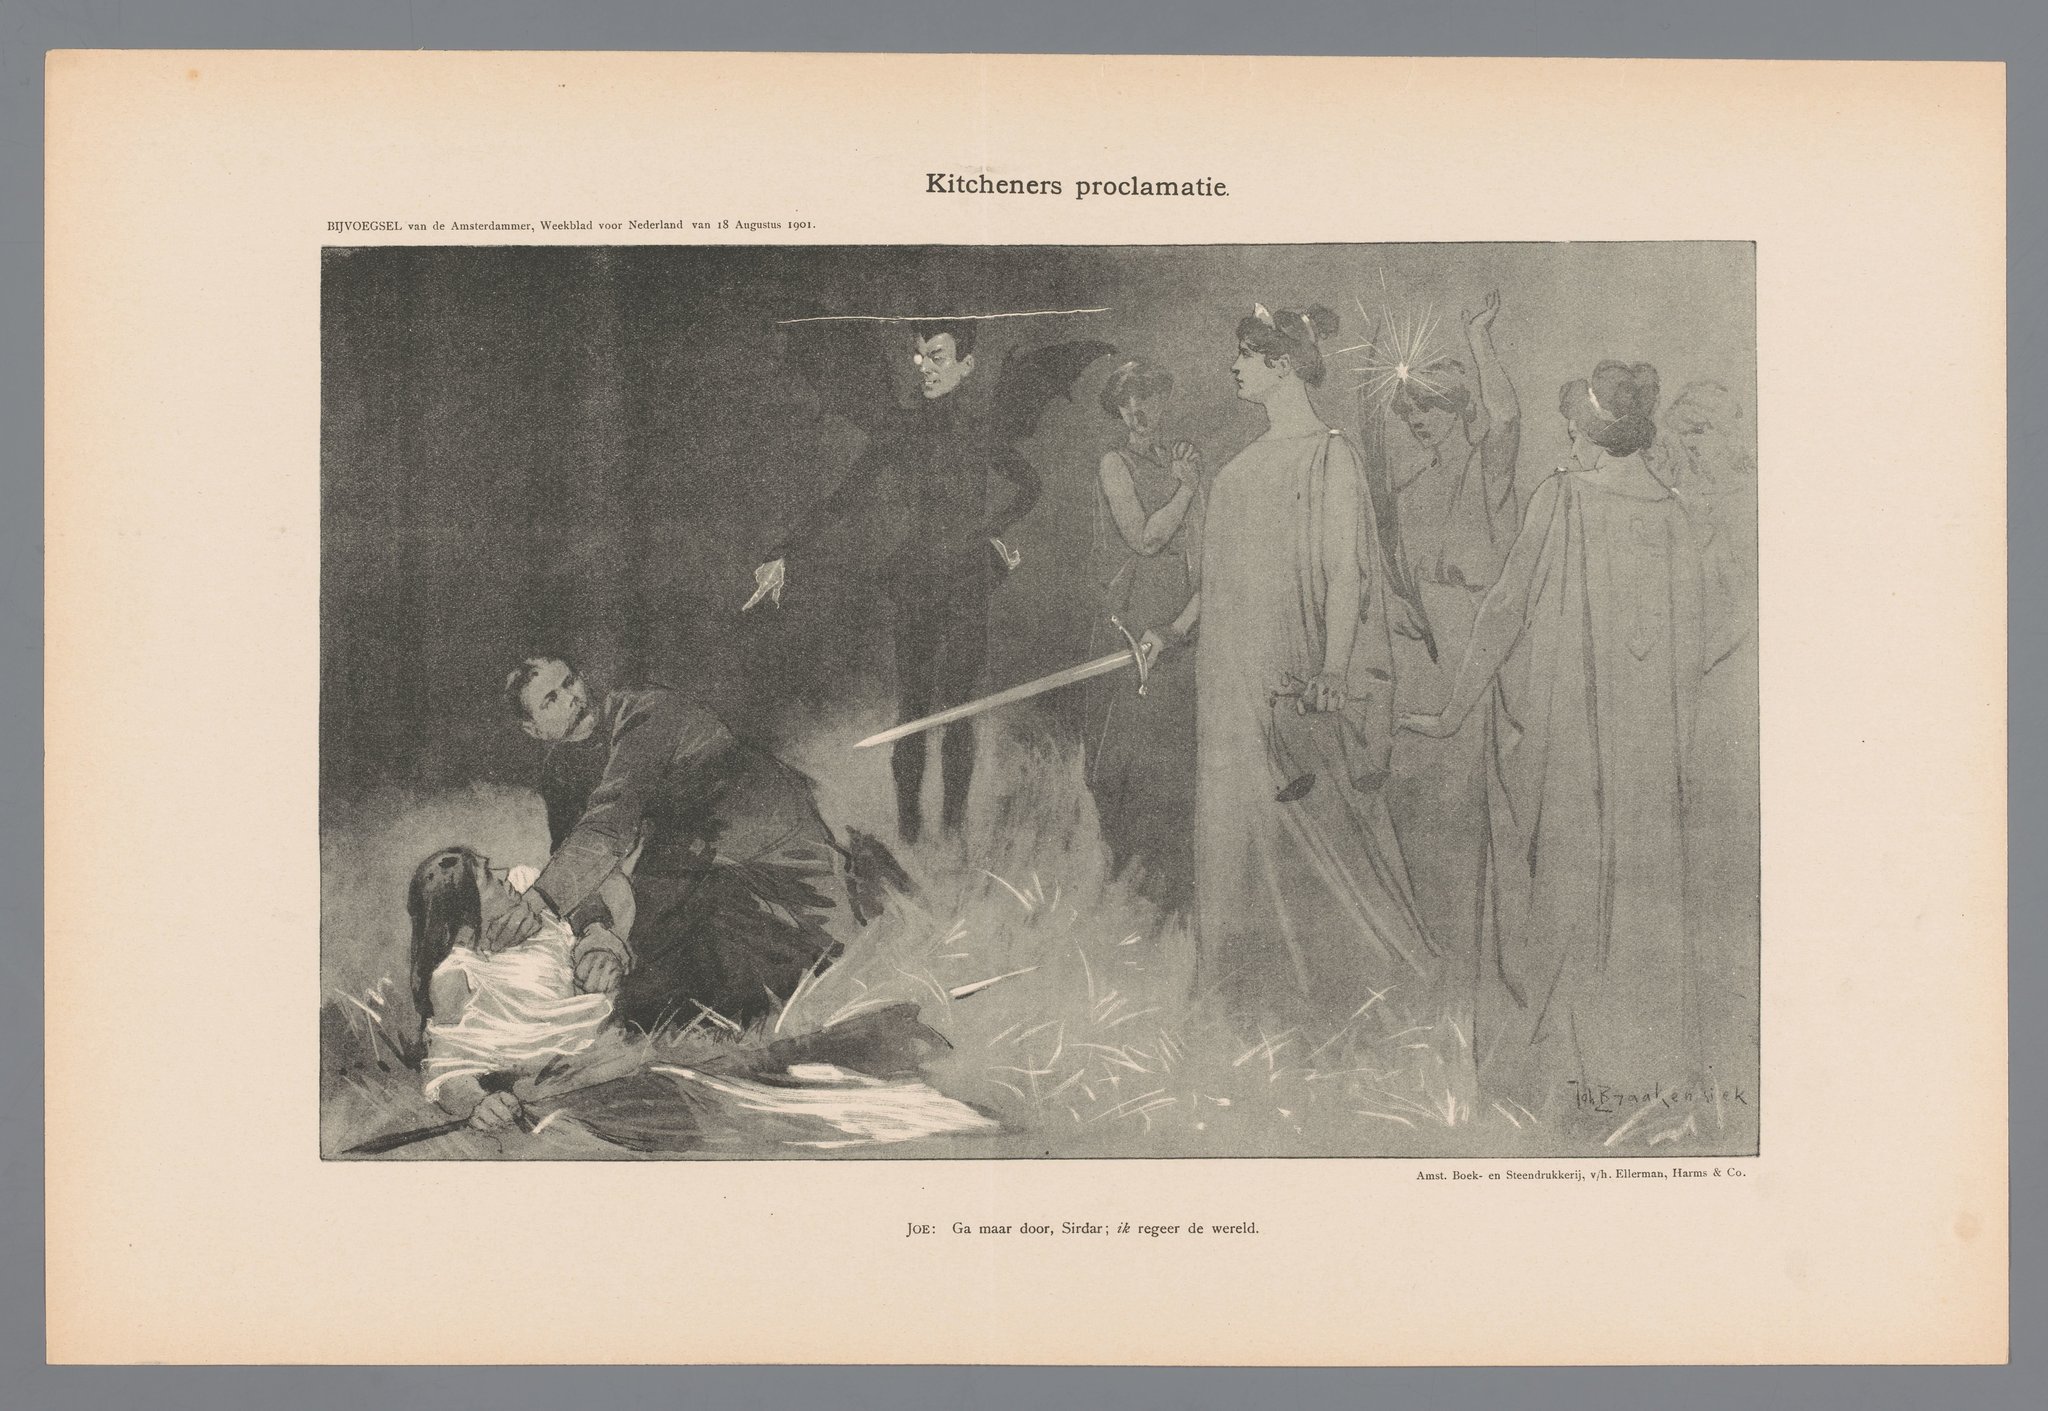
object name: cartoon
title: Kitcheners proclamatie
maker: johan braakensiek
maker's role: draughtsman, print maker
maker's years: 1858-1940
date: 1901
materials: paper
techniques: lithograph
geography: amsterdam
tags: horatio herbert kitchener, politician, political caricatures and satires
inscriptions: date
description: Prent uit het bijvoegsel van: De Amsterdammer. Weekblad voor Nederland, 18 augustus 1901.